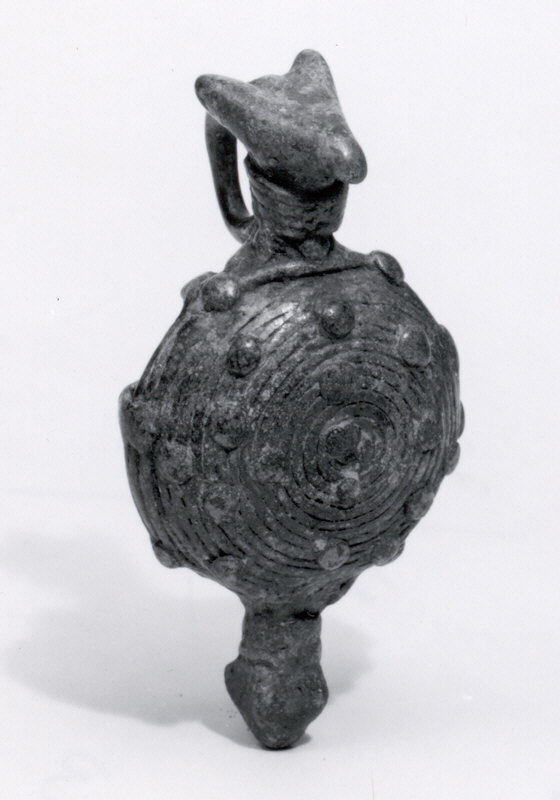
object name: pendant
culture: iranian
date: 1000-1 BCE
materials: bronze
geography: northwestern iran, caspian region